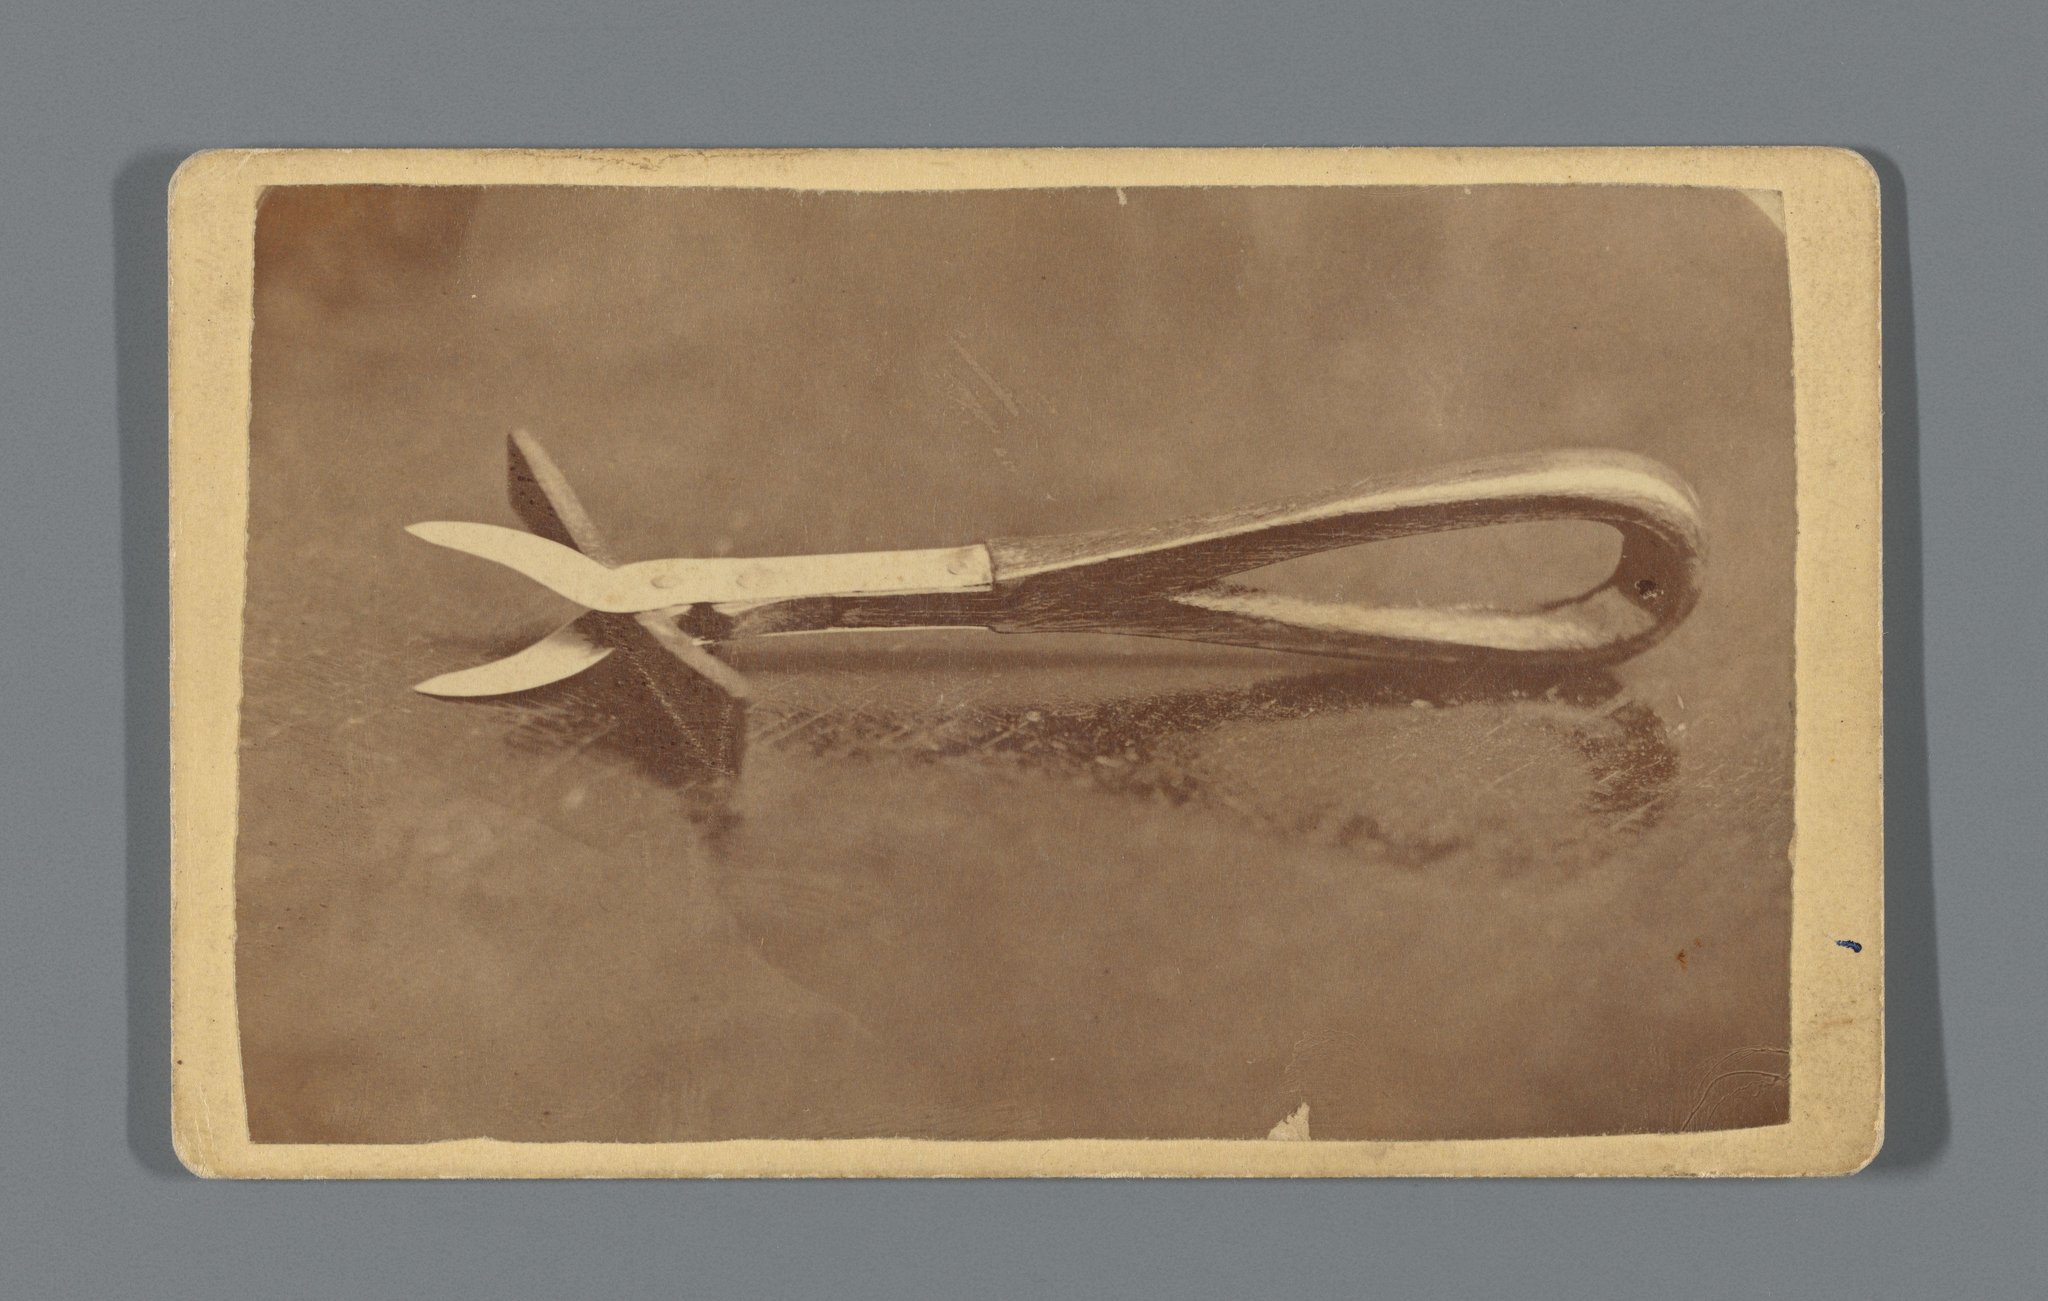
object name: photograph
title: Carte-de-visite van een instrument of gereedschap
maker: g.l. bates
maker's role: fotograaf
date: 1875-1890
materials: cardboard, paper, photographic support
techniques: albumen print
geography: prairie city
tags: new york (city)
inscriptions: inscription: ‘FROM / G.L. BATE'S / FINE ART GALLERY, / Prairie City. / IOWA. / Negatives Preserved’